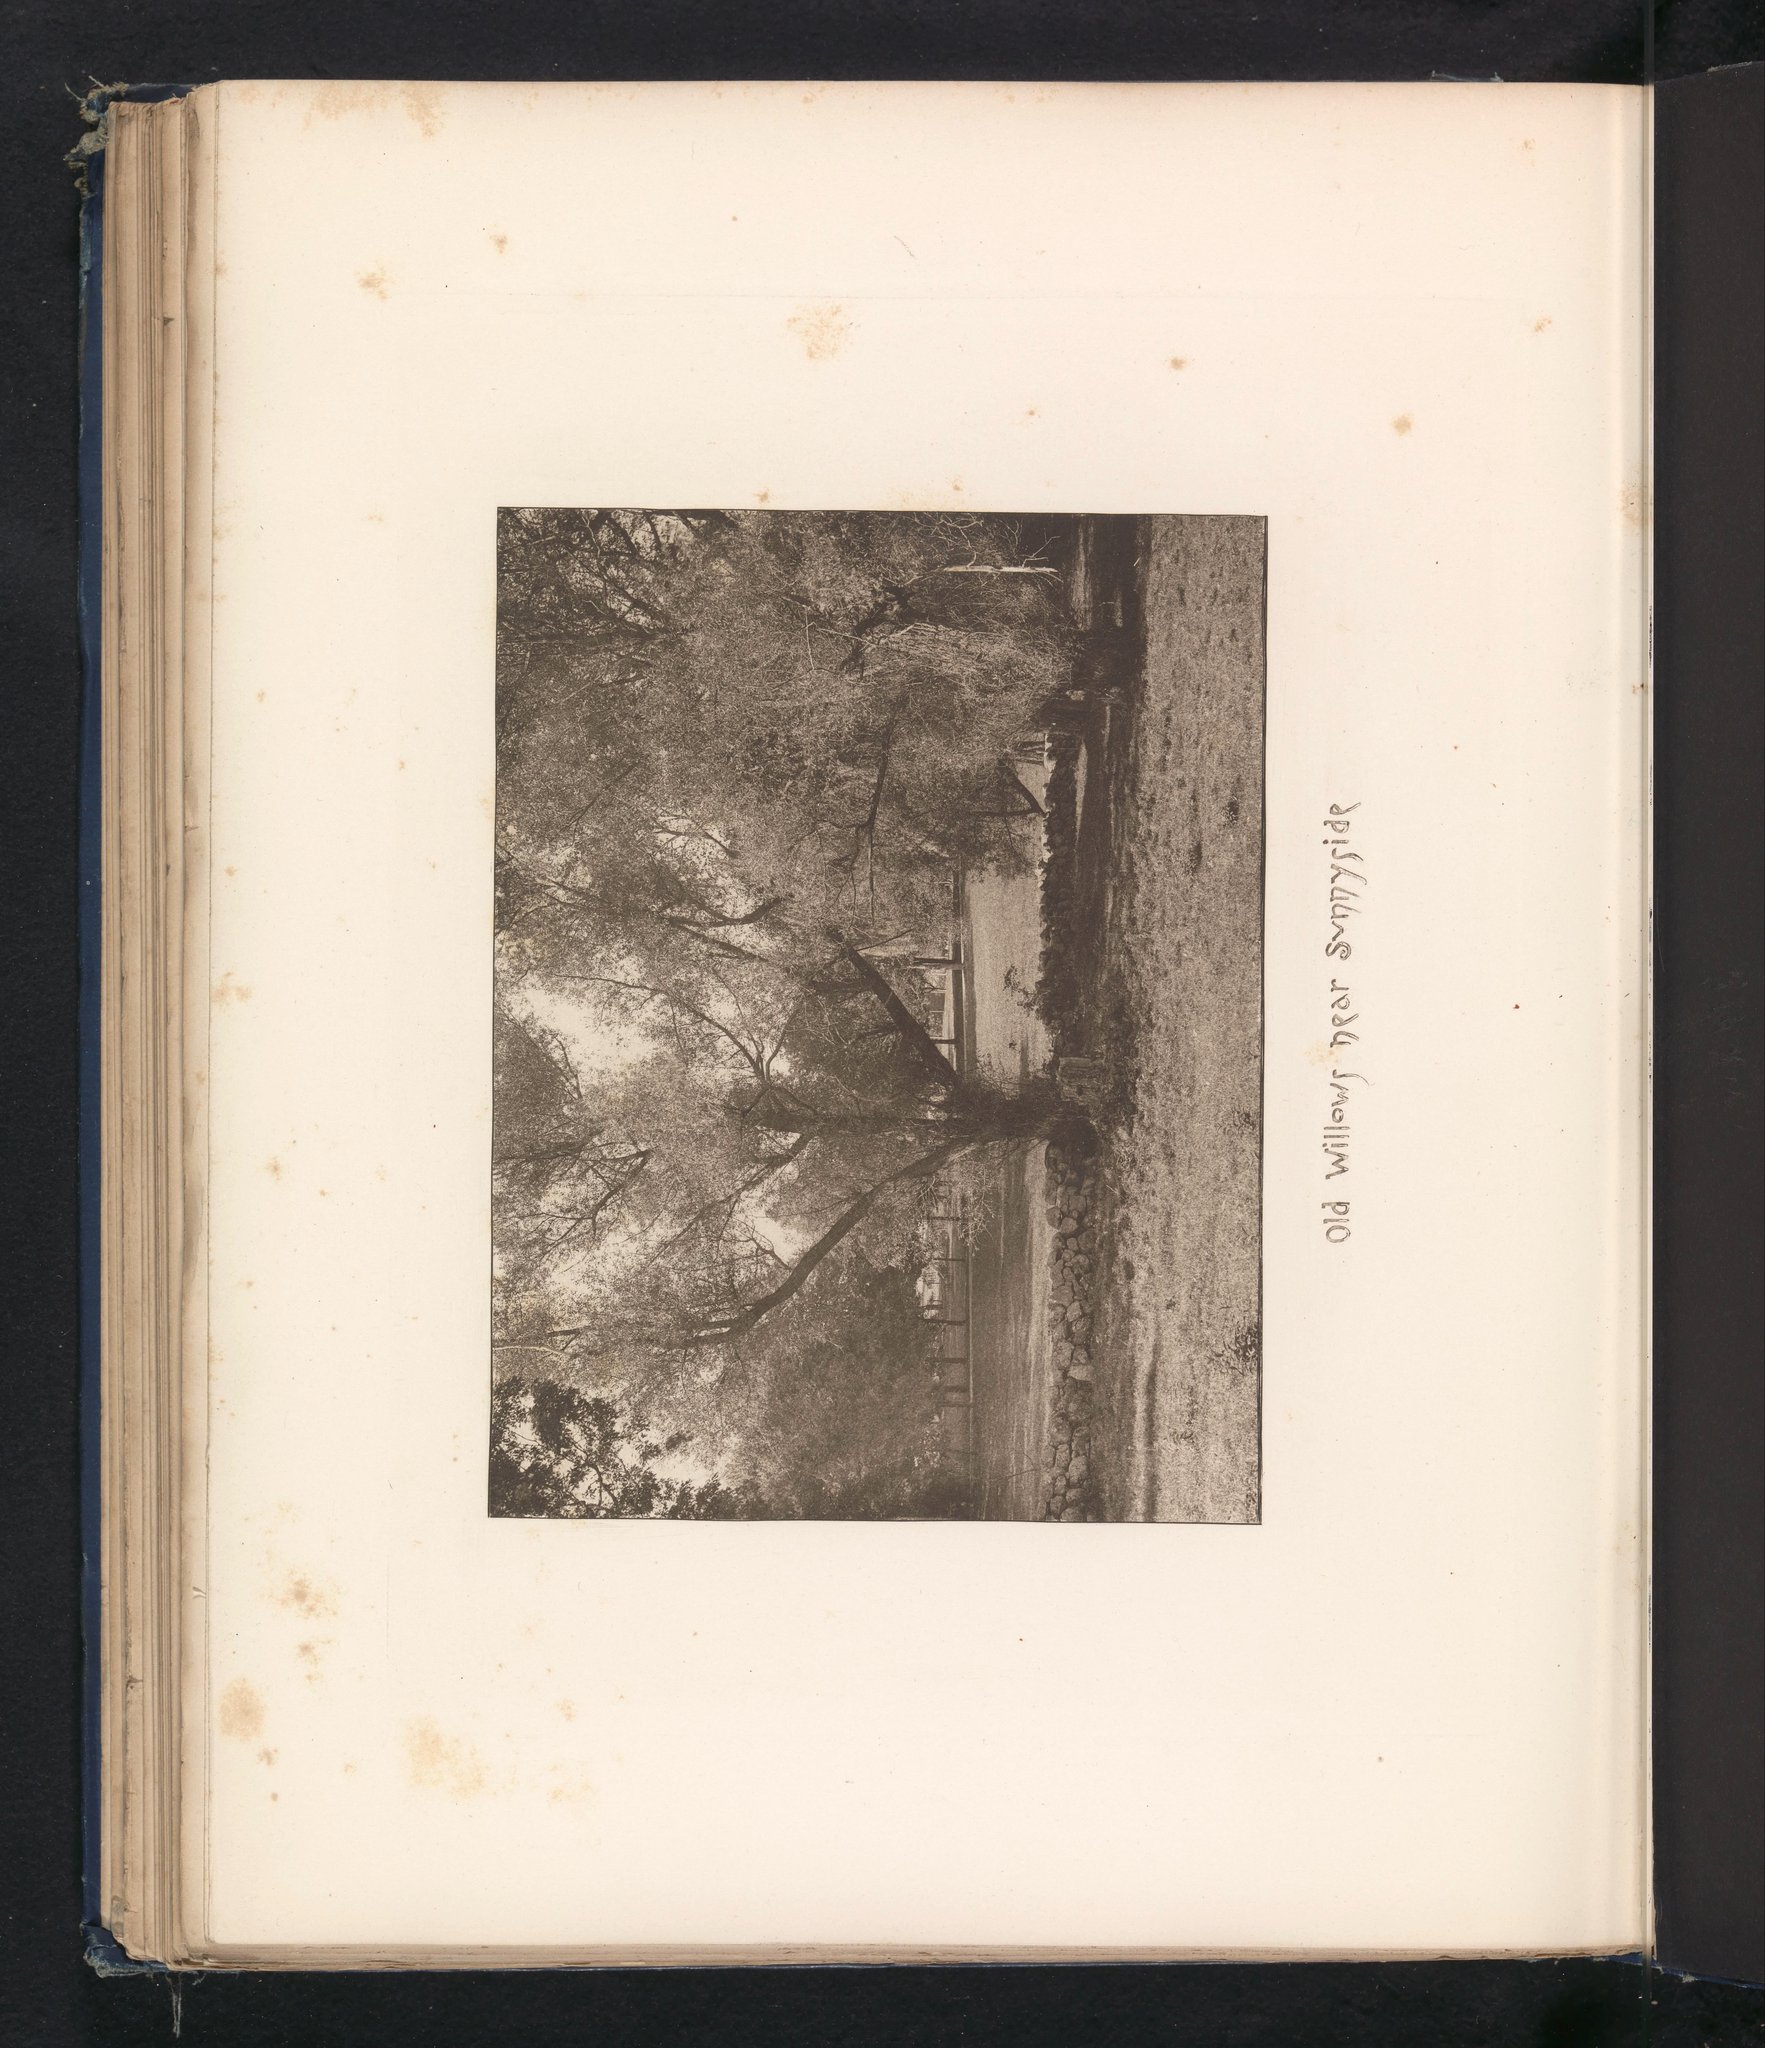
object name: photomechanical print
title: Wilgen op het landgoed van Sunnyside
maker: james leon williams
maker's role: fotograaf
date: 1882-1887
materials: paper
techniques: photoaquatint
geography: new york city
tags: trees: willow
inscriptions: inscription: ‘Old willows near Sunnyside’